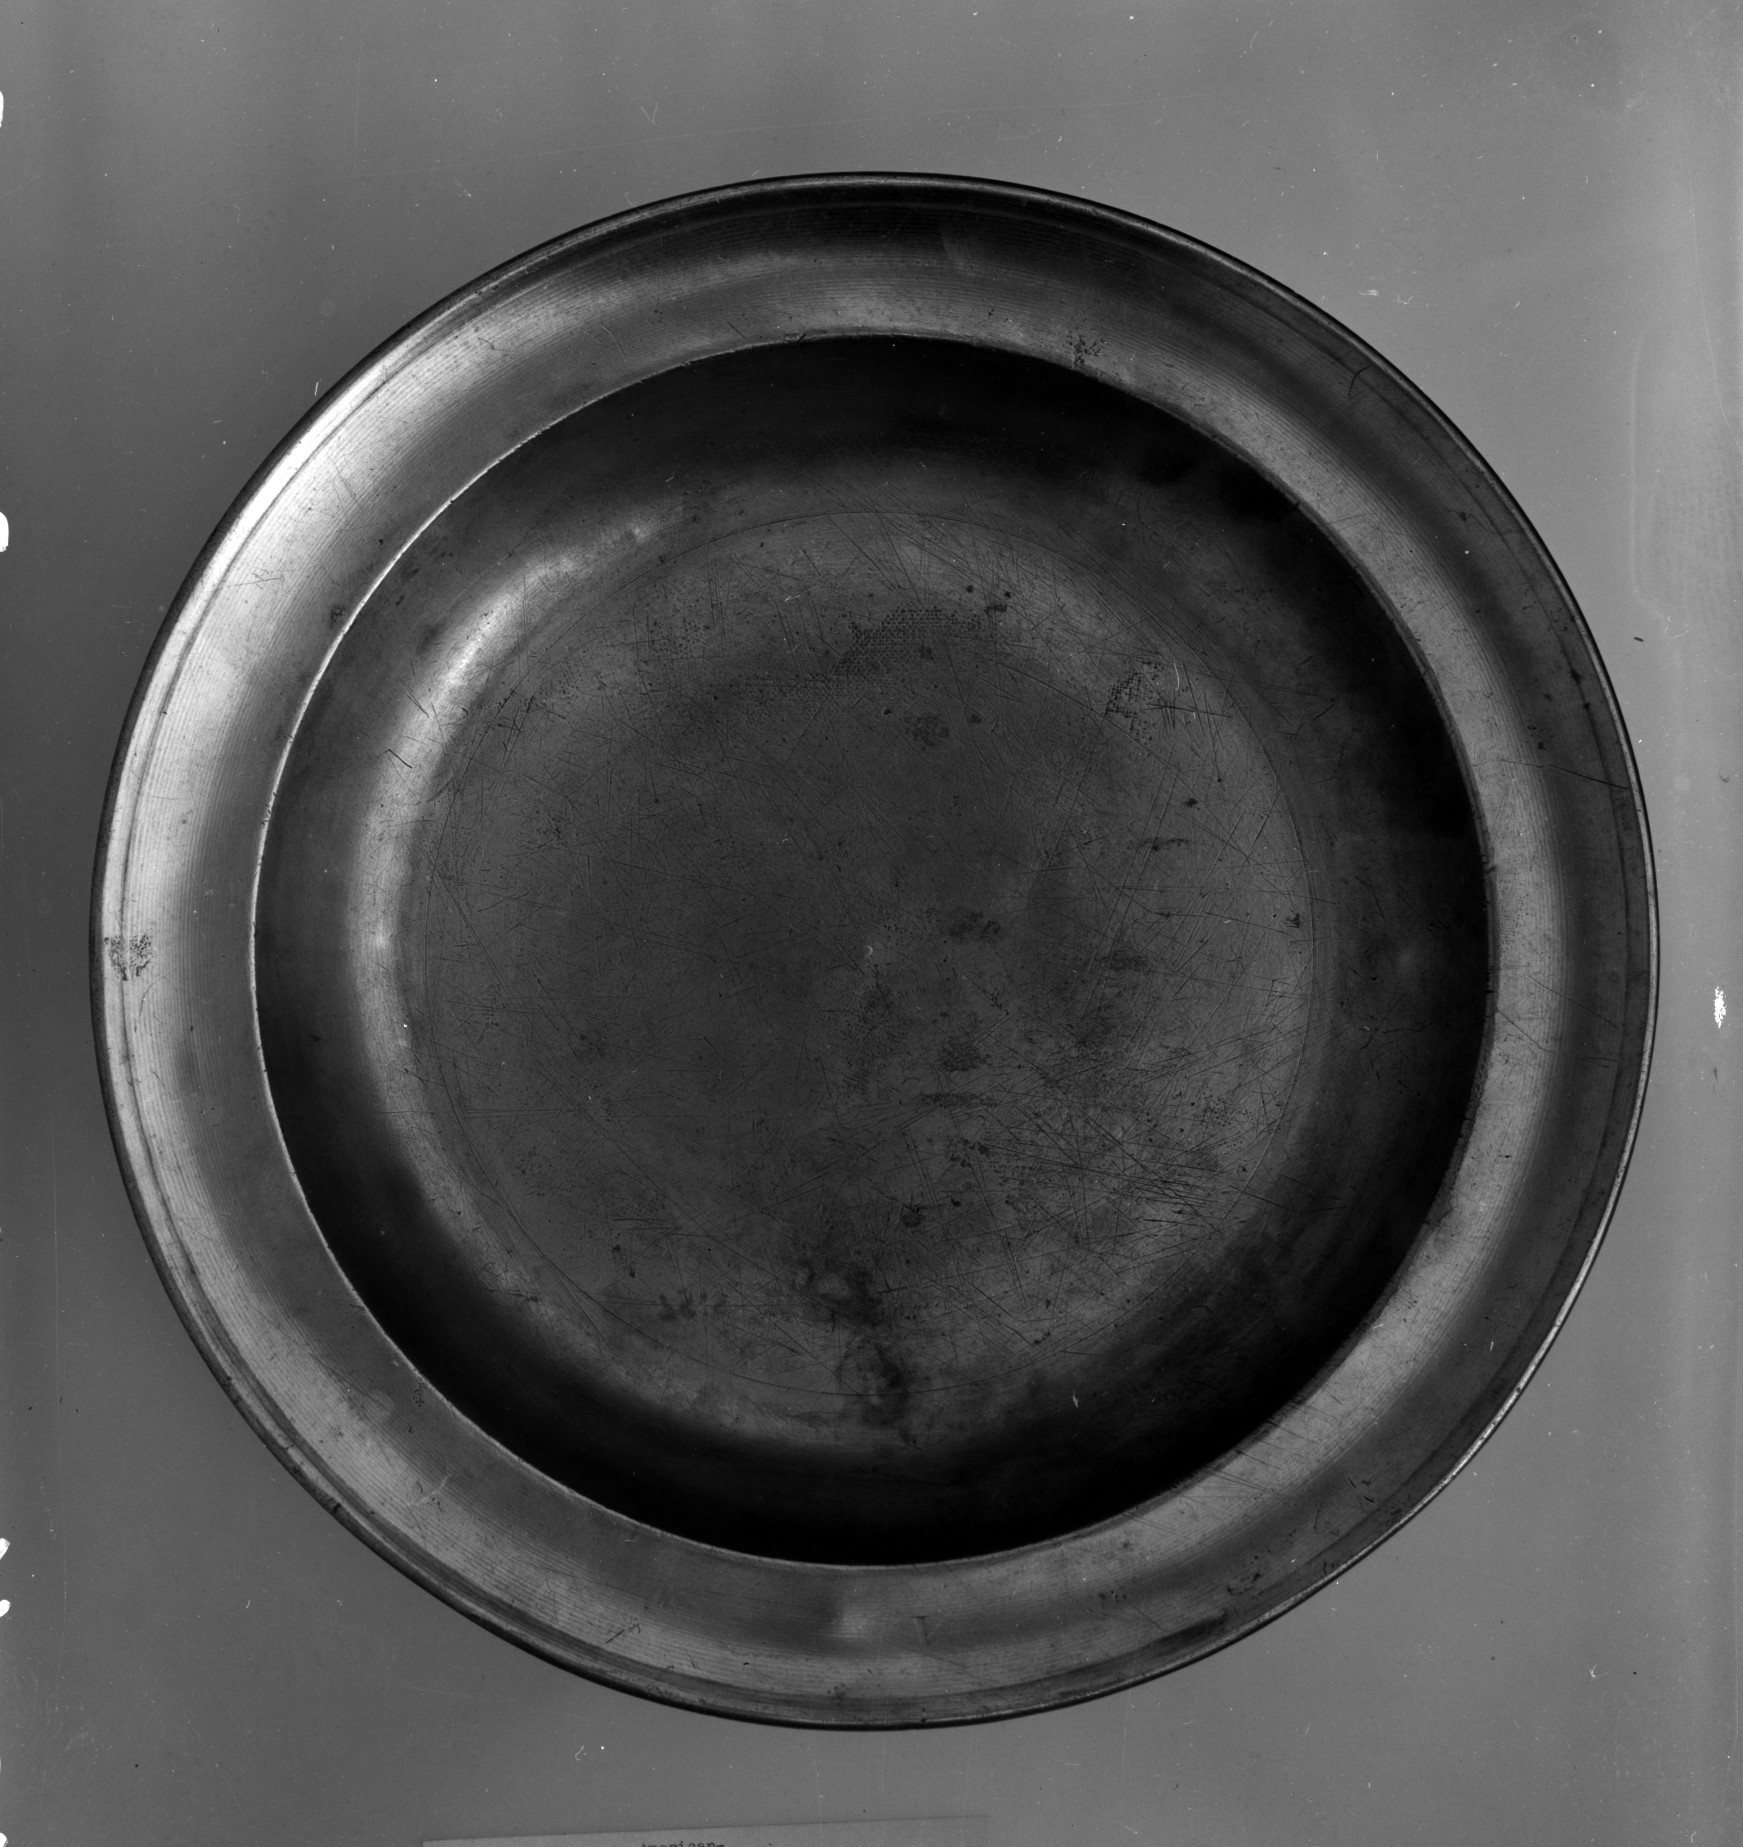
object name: dish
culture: american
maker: george lightner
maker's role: maker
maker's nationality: american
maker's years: 1749-1815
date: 1806-1815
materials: pewter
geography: united states